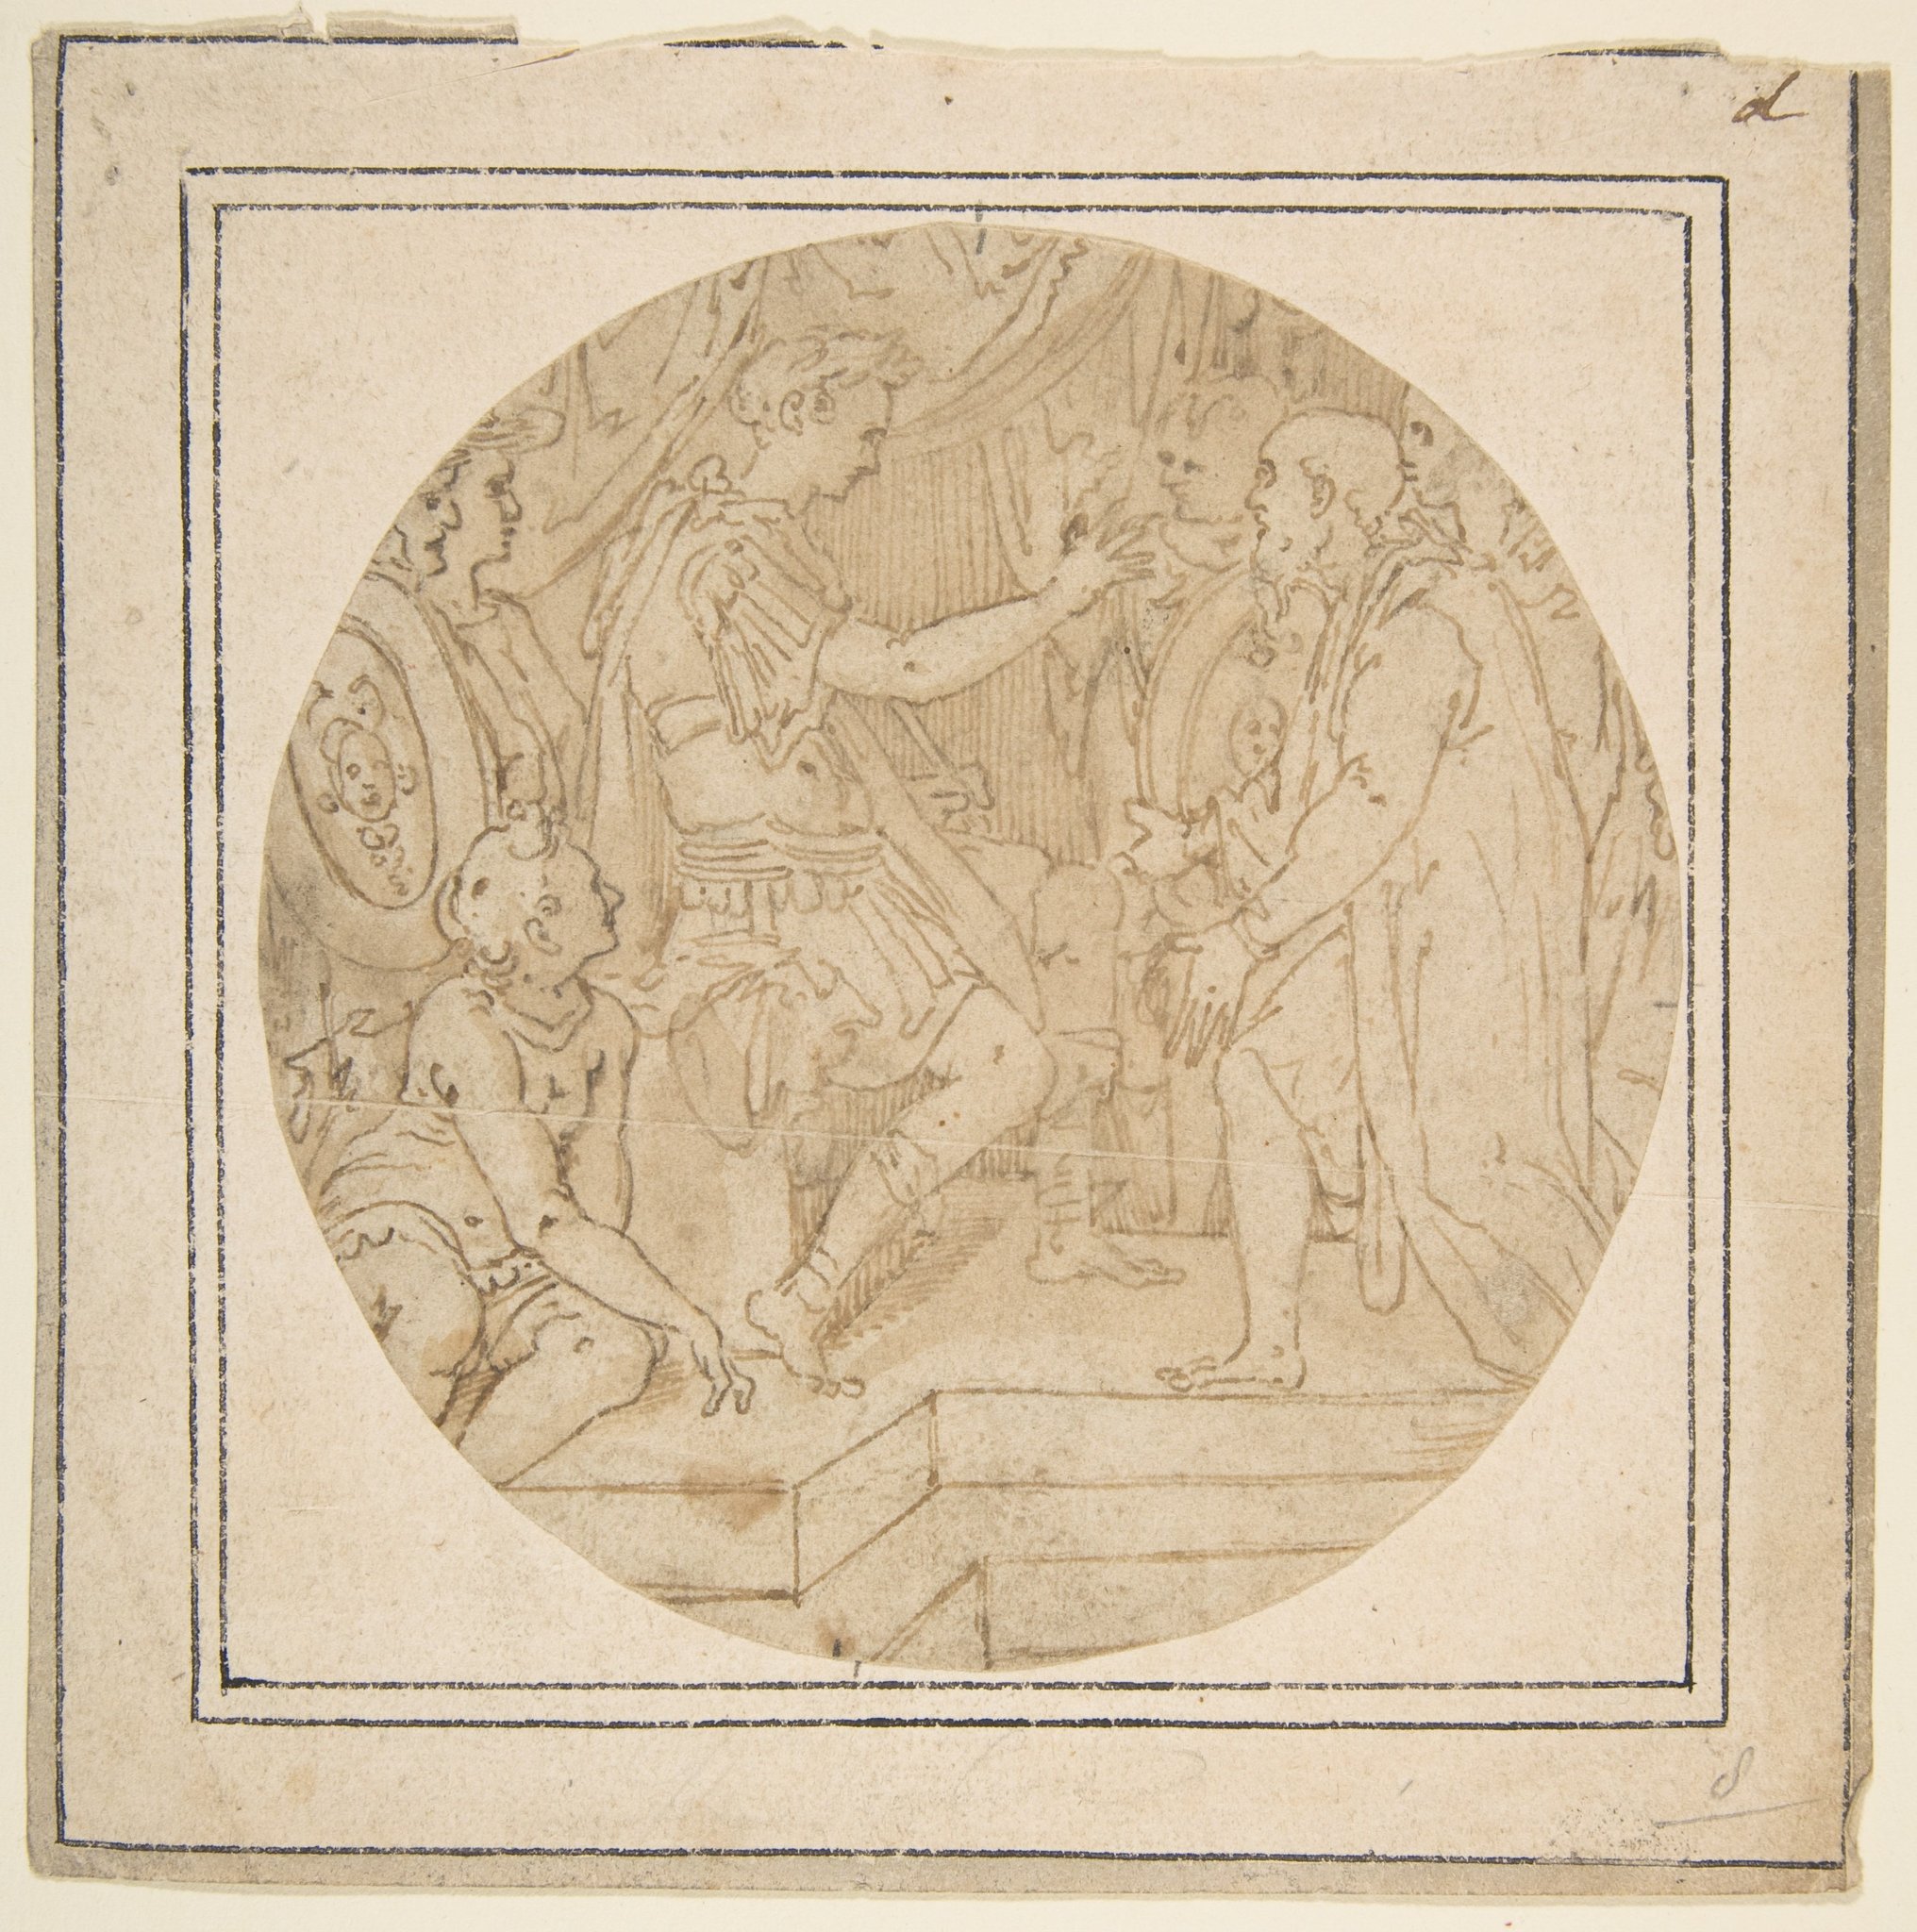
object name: drawing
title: Drawing of a Roman Emperor Receiving a Petition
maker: federico zuccaro (zuccari)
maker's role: artist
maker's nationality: italian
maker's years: 1540-1609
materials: ink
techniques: pen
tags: shields,men